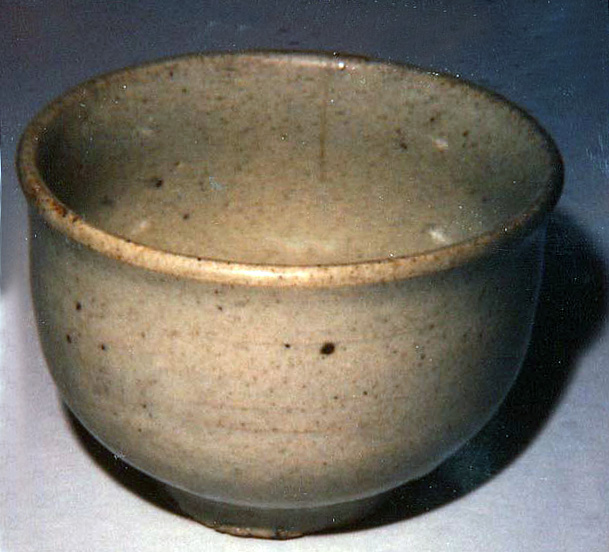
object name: bowl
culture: korean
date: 1701-1900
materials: glaze, porcelain